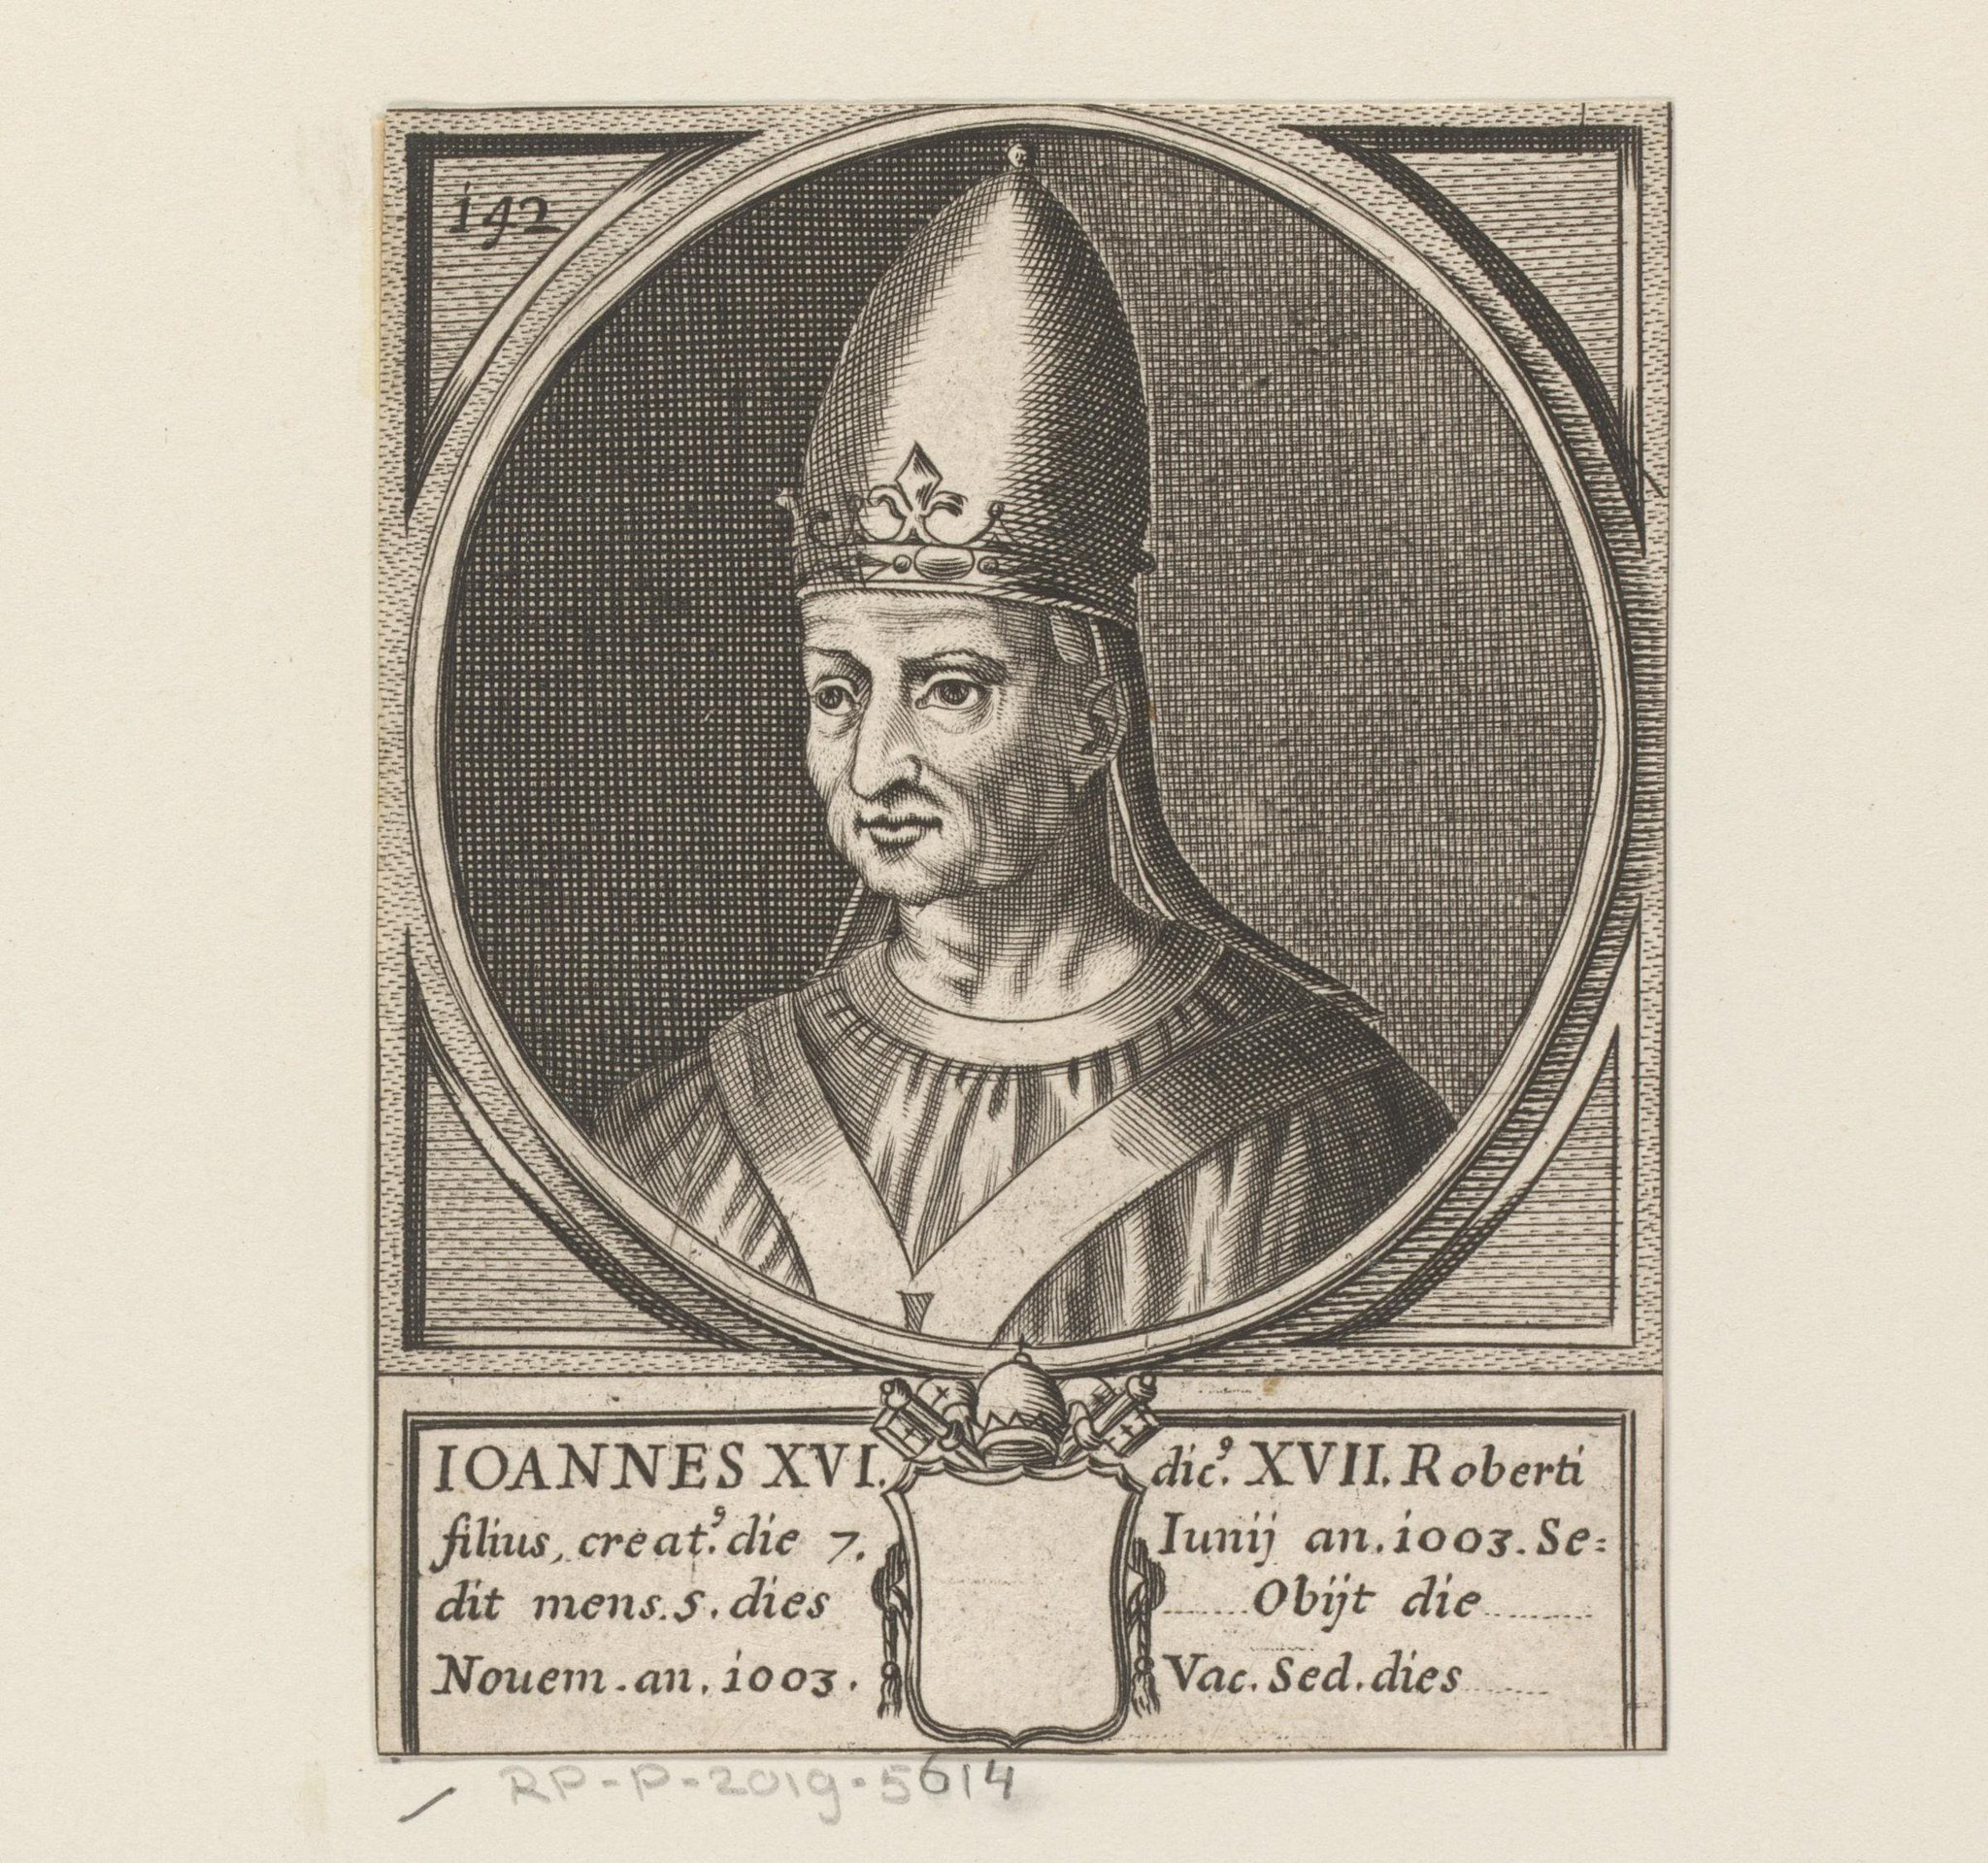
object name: print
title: Portret van tegenpaus Johannes XVI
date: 1675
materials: paper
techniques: engraving, etching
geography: rome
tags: historical persons, pope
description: Portret afkomstig uit een grote prent, bestaande uit 17 bladen die samengevoegd konden worden, uitgegeven door Giovanni Giacomo de' Rossi in 1675.